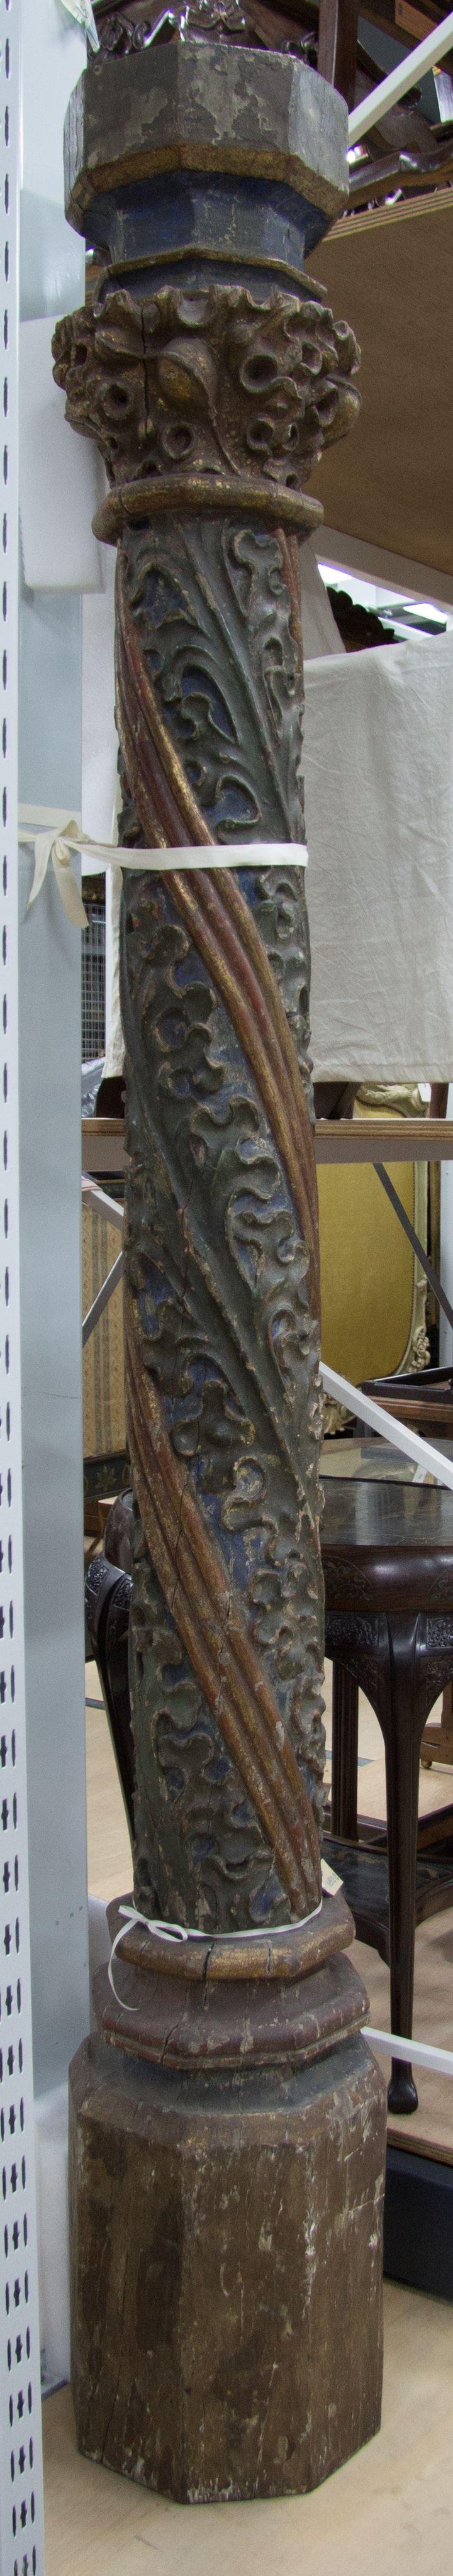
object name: sculpture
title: Bouwfragment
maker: Anonymous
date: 1500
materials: wood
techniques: painted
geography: france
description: Gebeeldhouwde kolom van blauwgroen gepolychromeerd hout op een achthoekige basis. De schacht vertoont geslingerde banden, waartussen gestileerd bladwerk. Het kapiteel vertoont gedeeltelijk opengewerkt laat-Gotisch bladwerk, waartussen vruchten zijn aangebracht. De kolom eindigt aan beide zijden in een onbewerkt gedeelte dat oorspronkelijk in de vloer en zolder was opgenomen. Zie tevens: BK-16863-a.